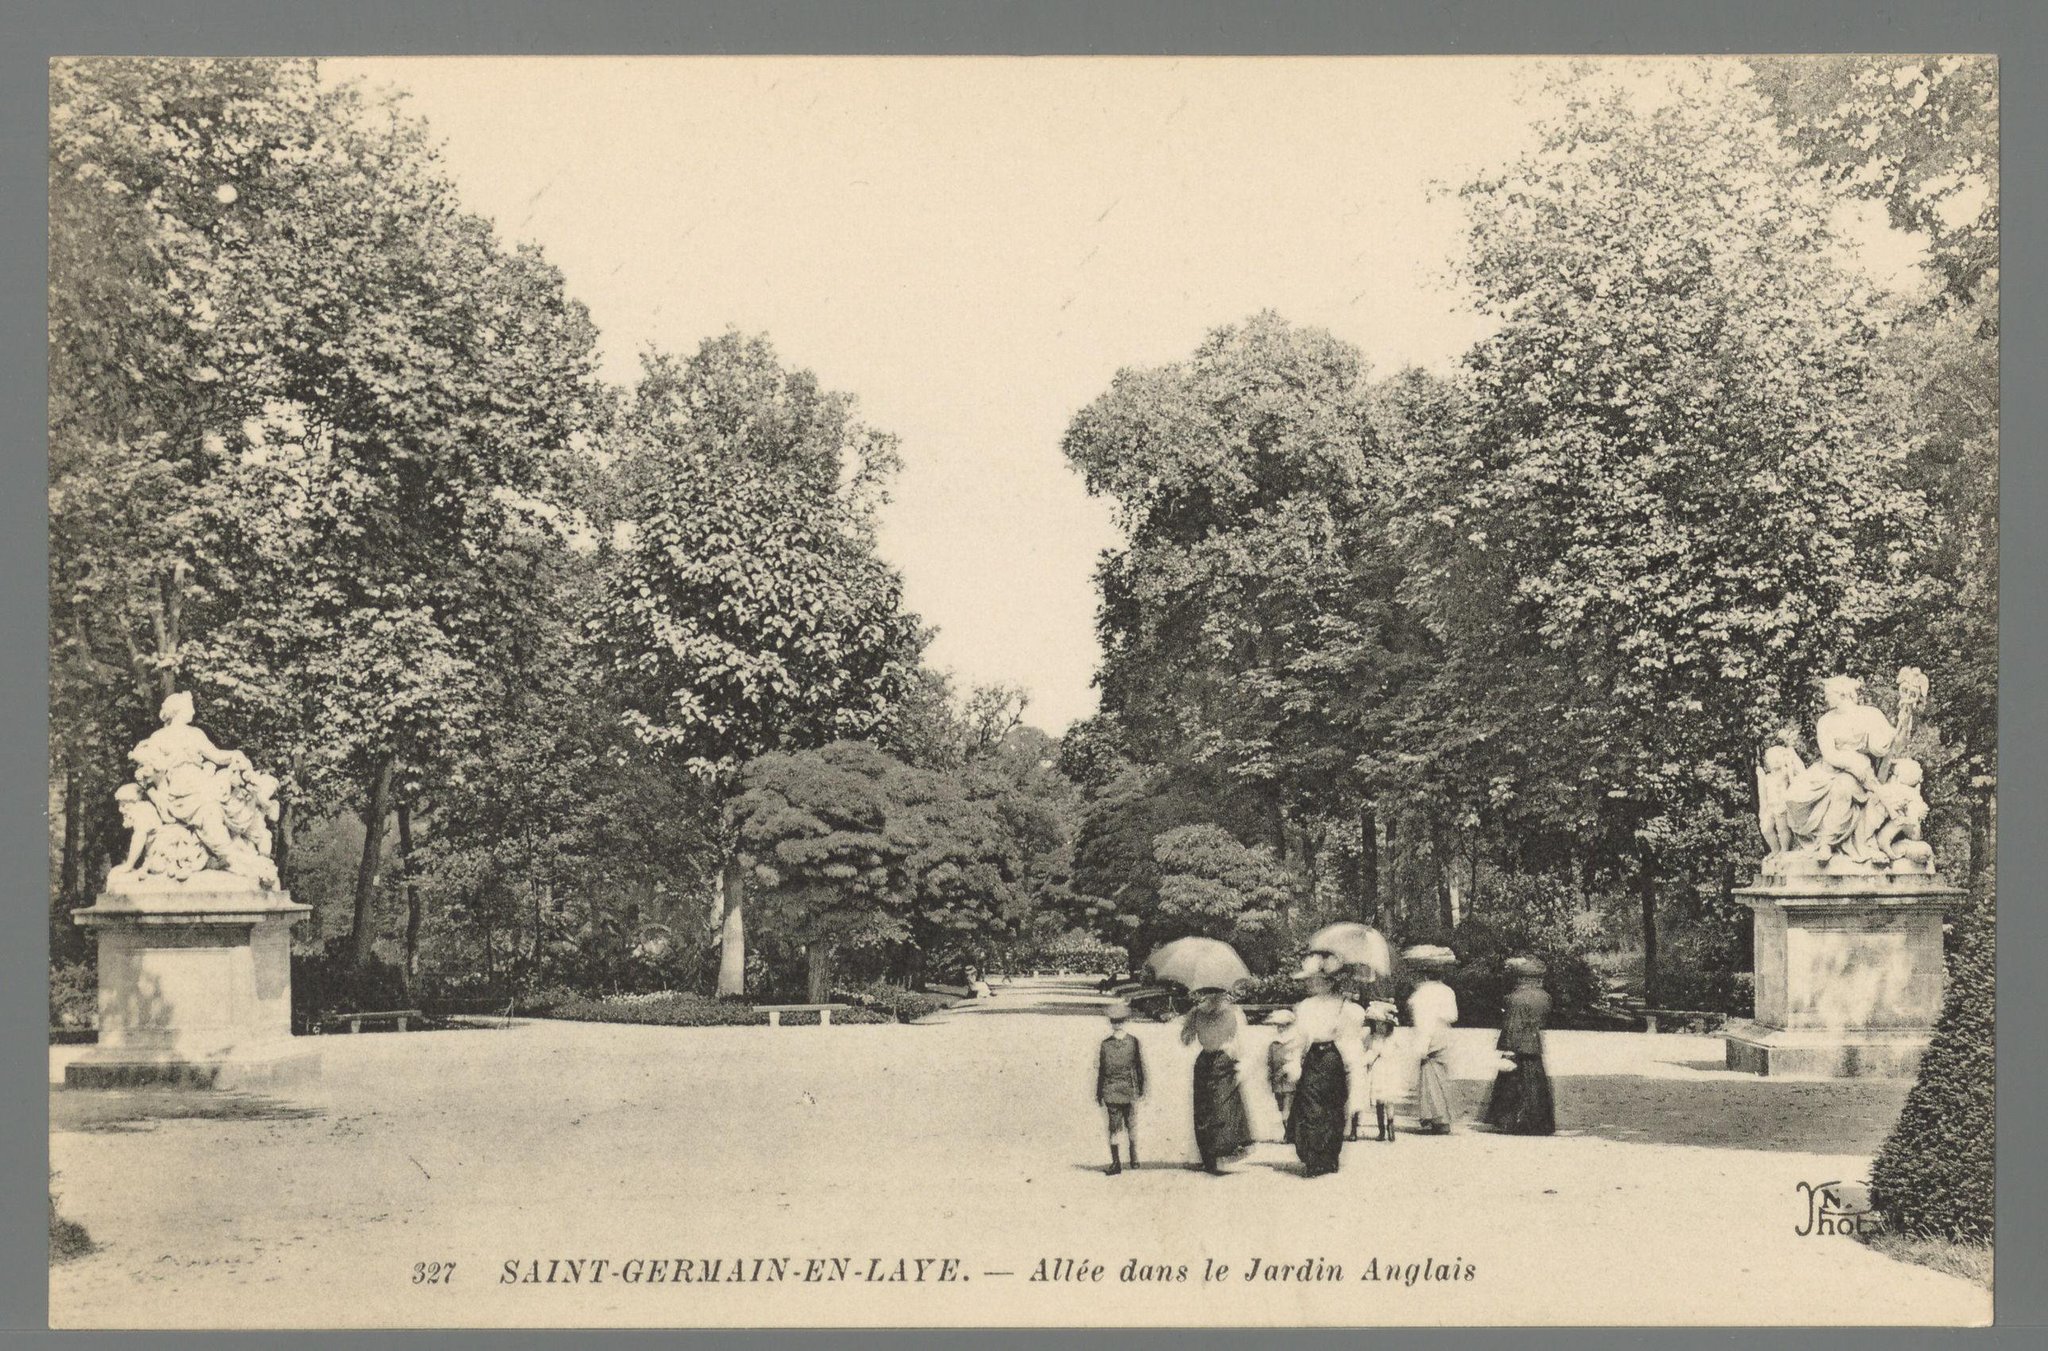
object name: photomechanical print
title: Saint-Germain-en-Laye. Allée dans le Jardin Anglais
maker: Anonymous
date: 1903-1918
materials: cardboard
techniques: photograph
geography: paris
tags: public gardens, park (+ city(-scape) with figures, staffage), statues, sculptures in garden